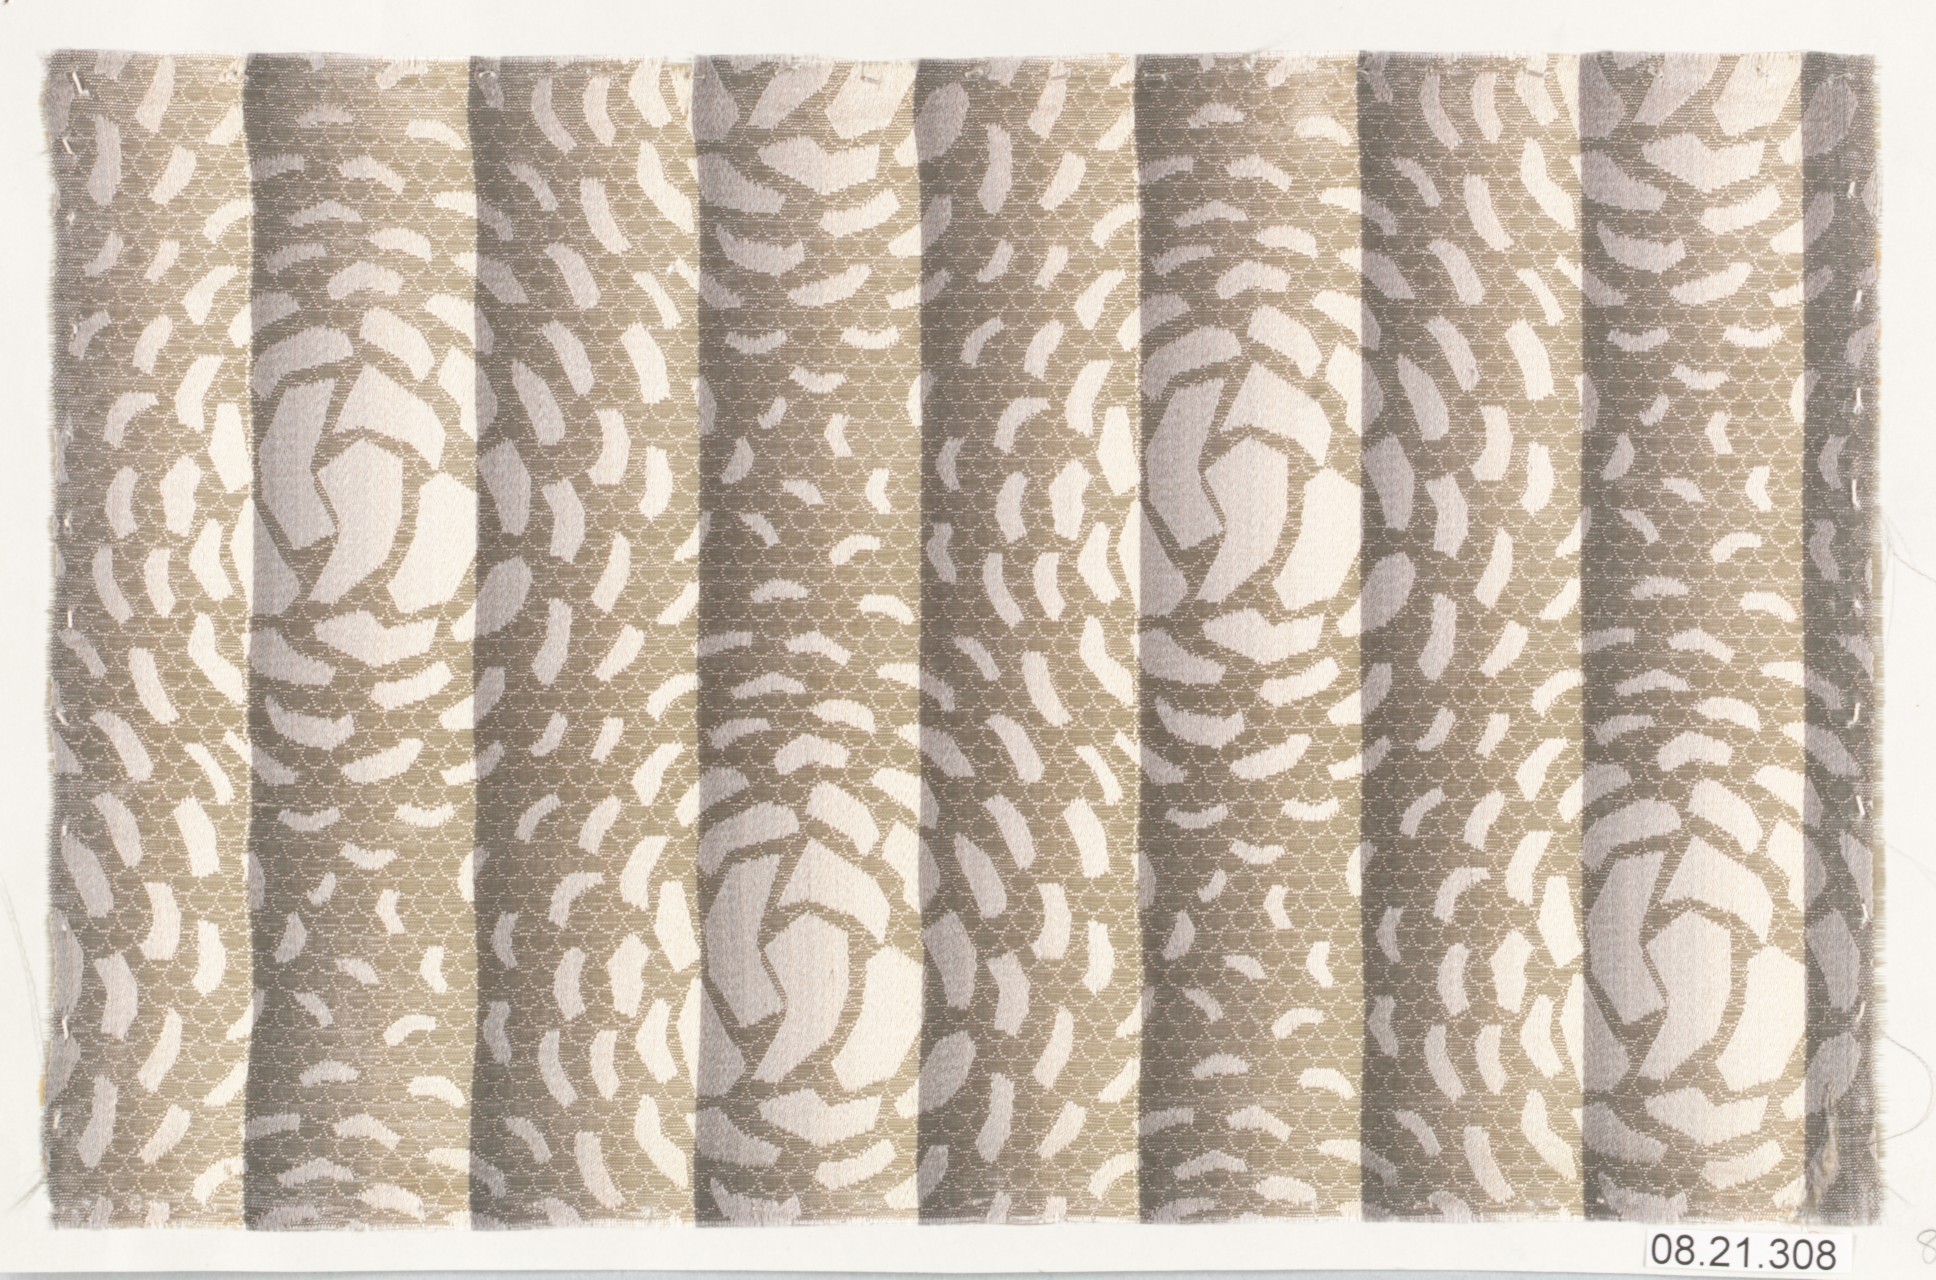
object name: textile sample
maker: Anonymous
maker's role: designer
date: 1900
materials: silk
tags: flowers